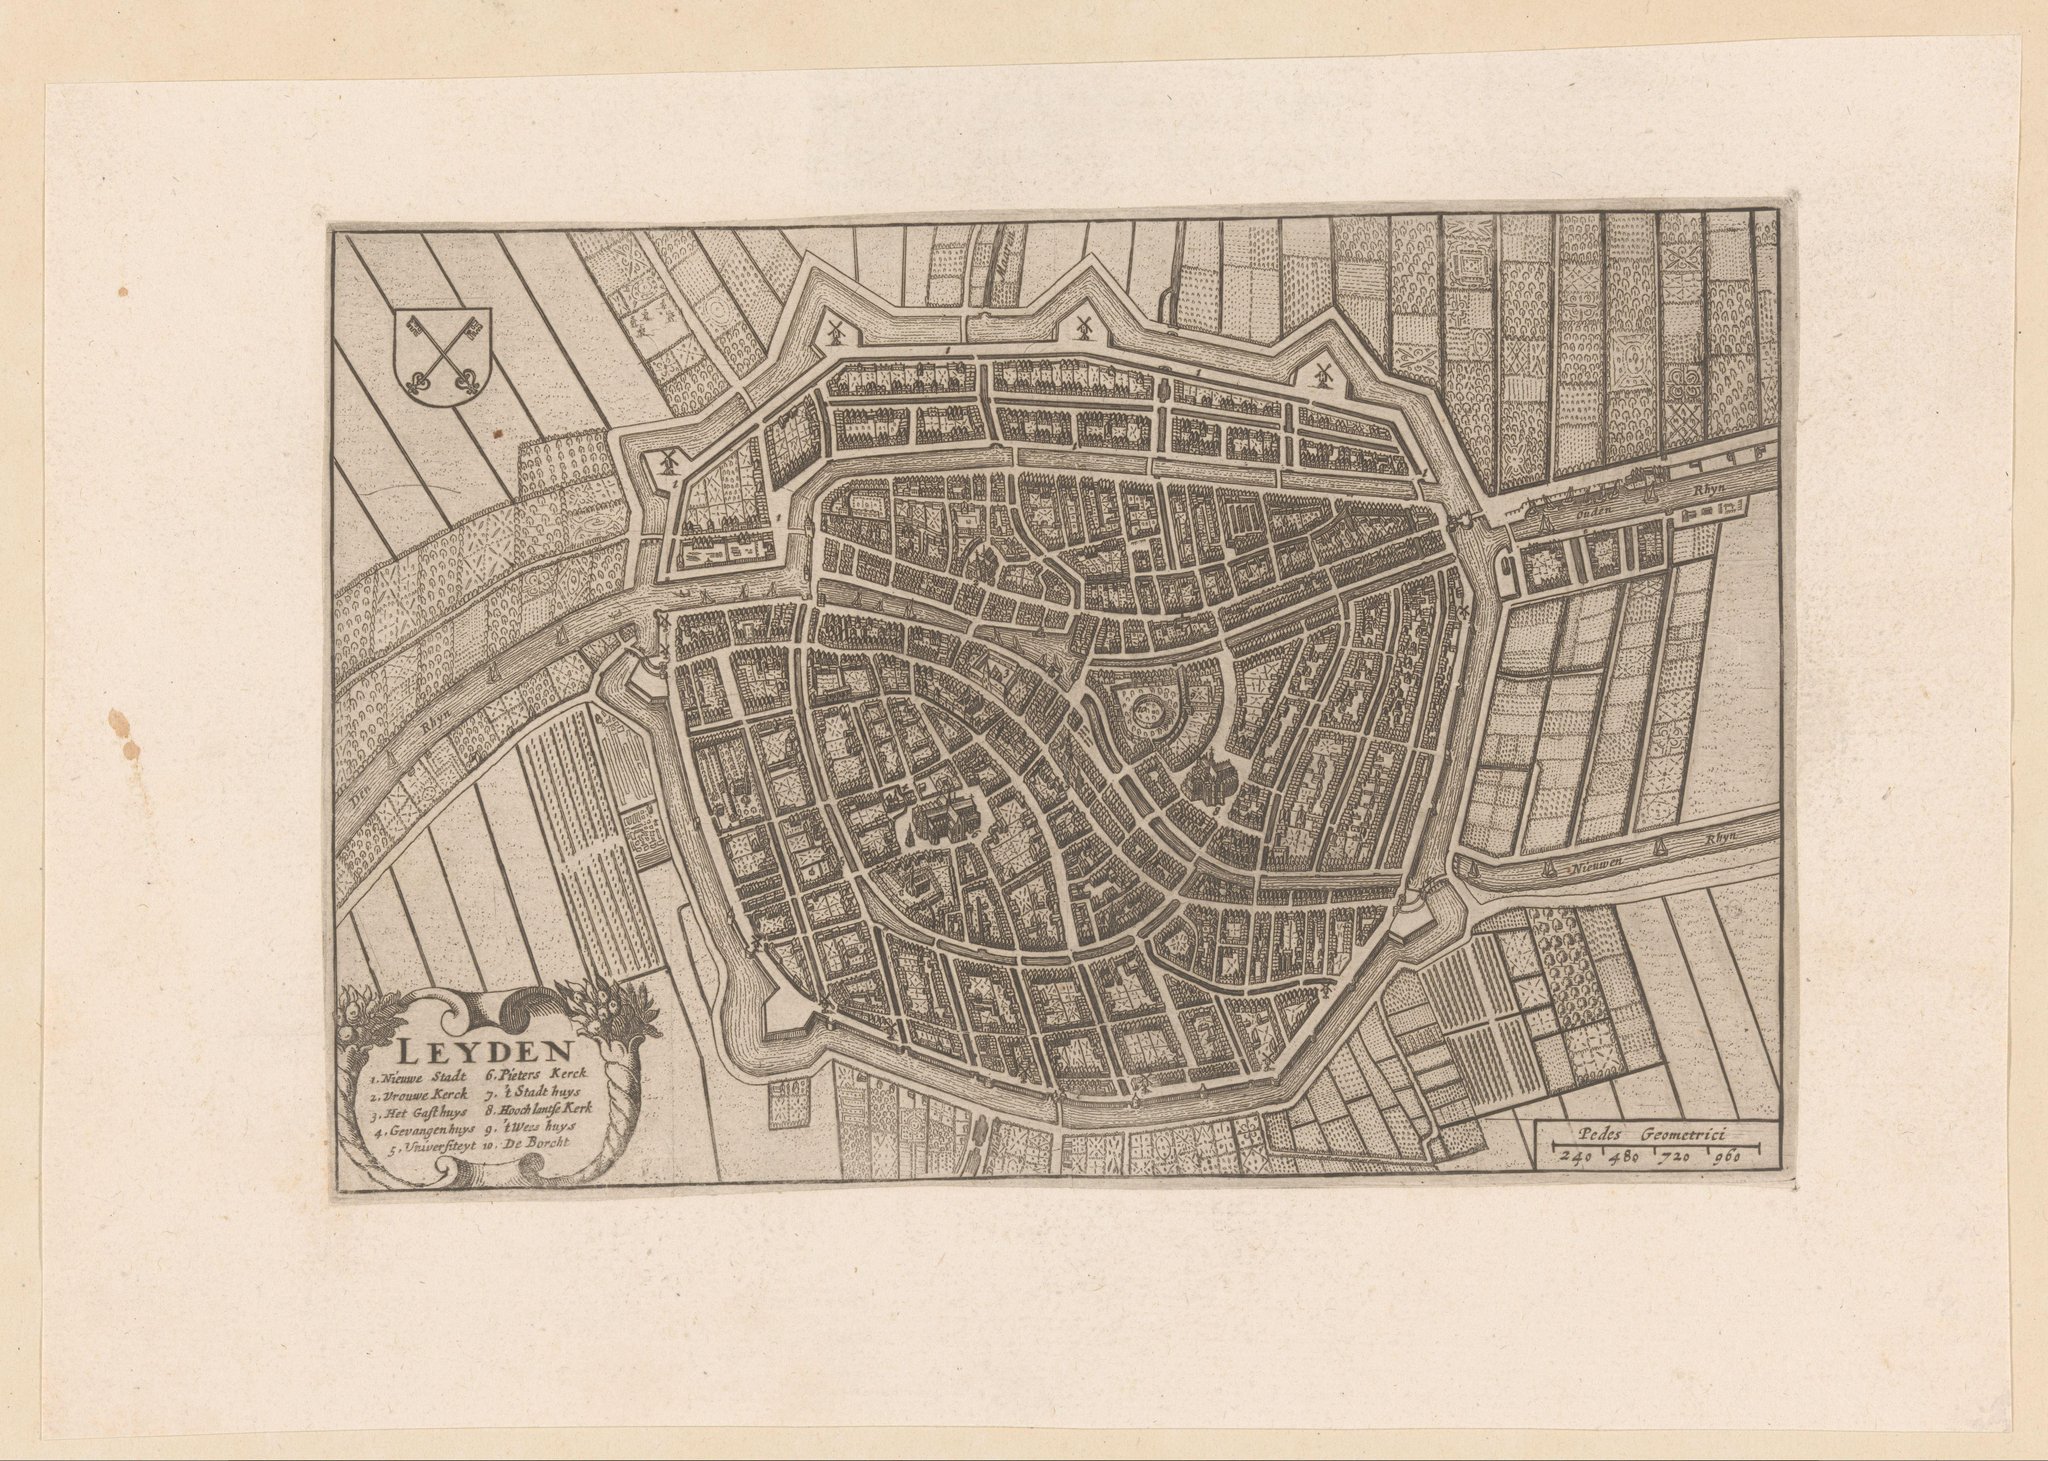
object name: book illustration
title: Plattegrond van Leiden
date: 1632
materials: paper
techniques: etching, letterpress printing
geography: amsterdam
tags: maps of cities, leiden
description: Prent uit: Boxhorn, Marcus Zuerius. Theatrum sive Hollandiae comitatus et urbium nova descriptio (...). Amsterdam: Henricus Hondius, 1632, p. 180.